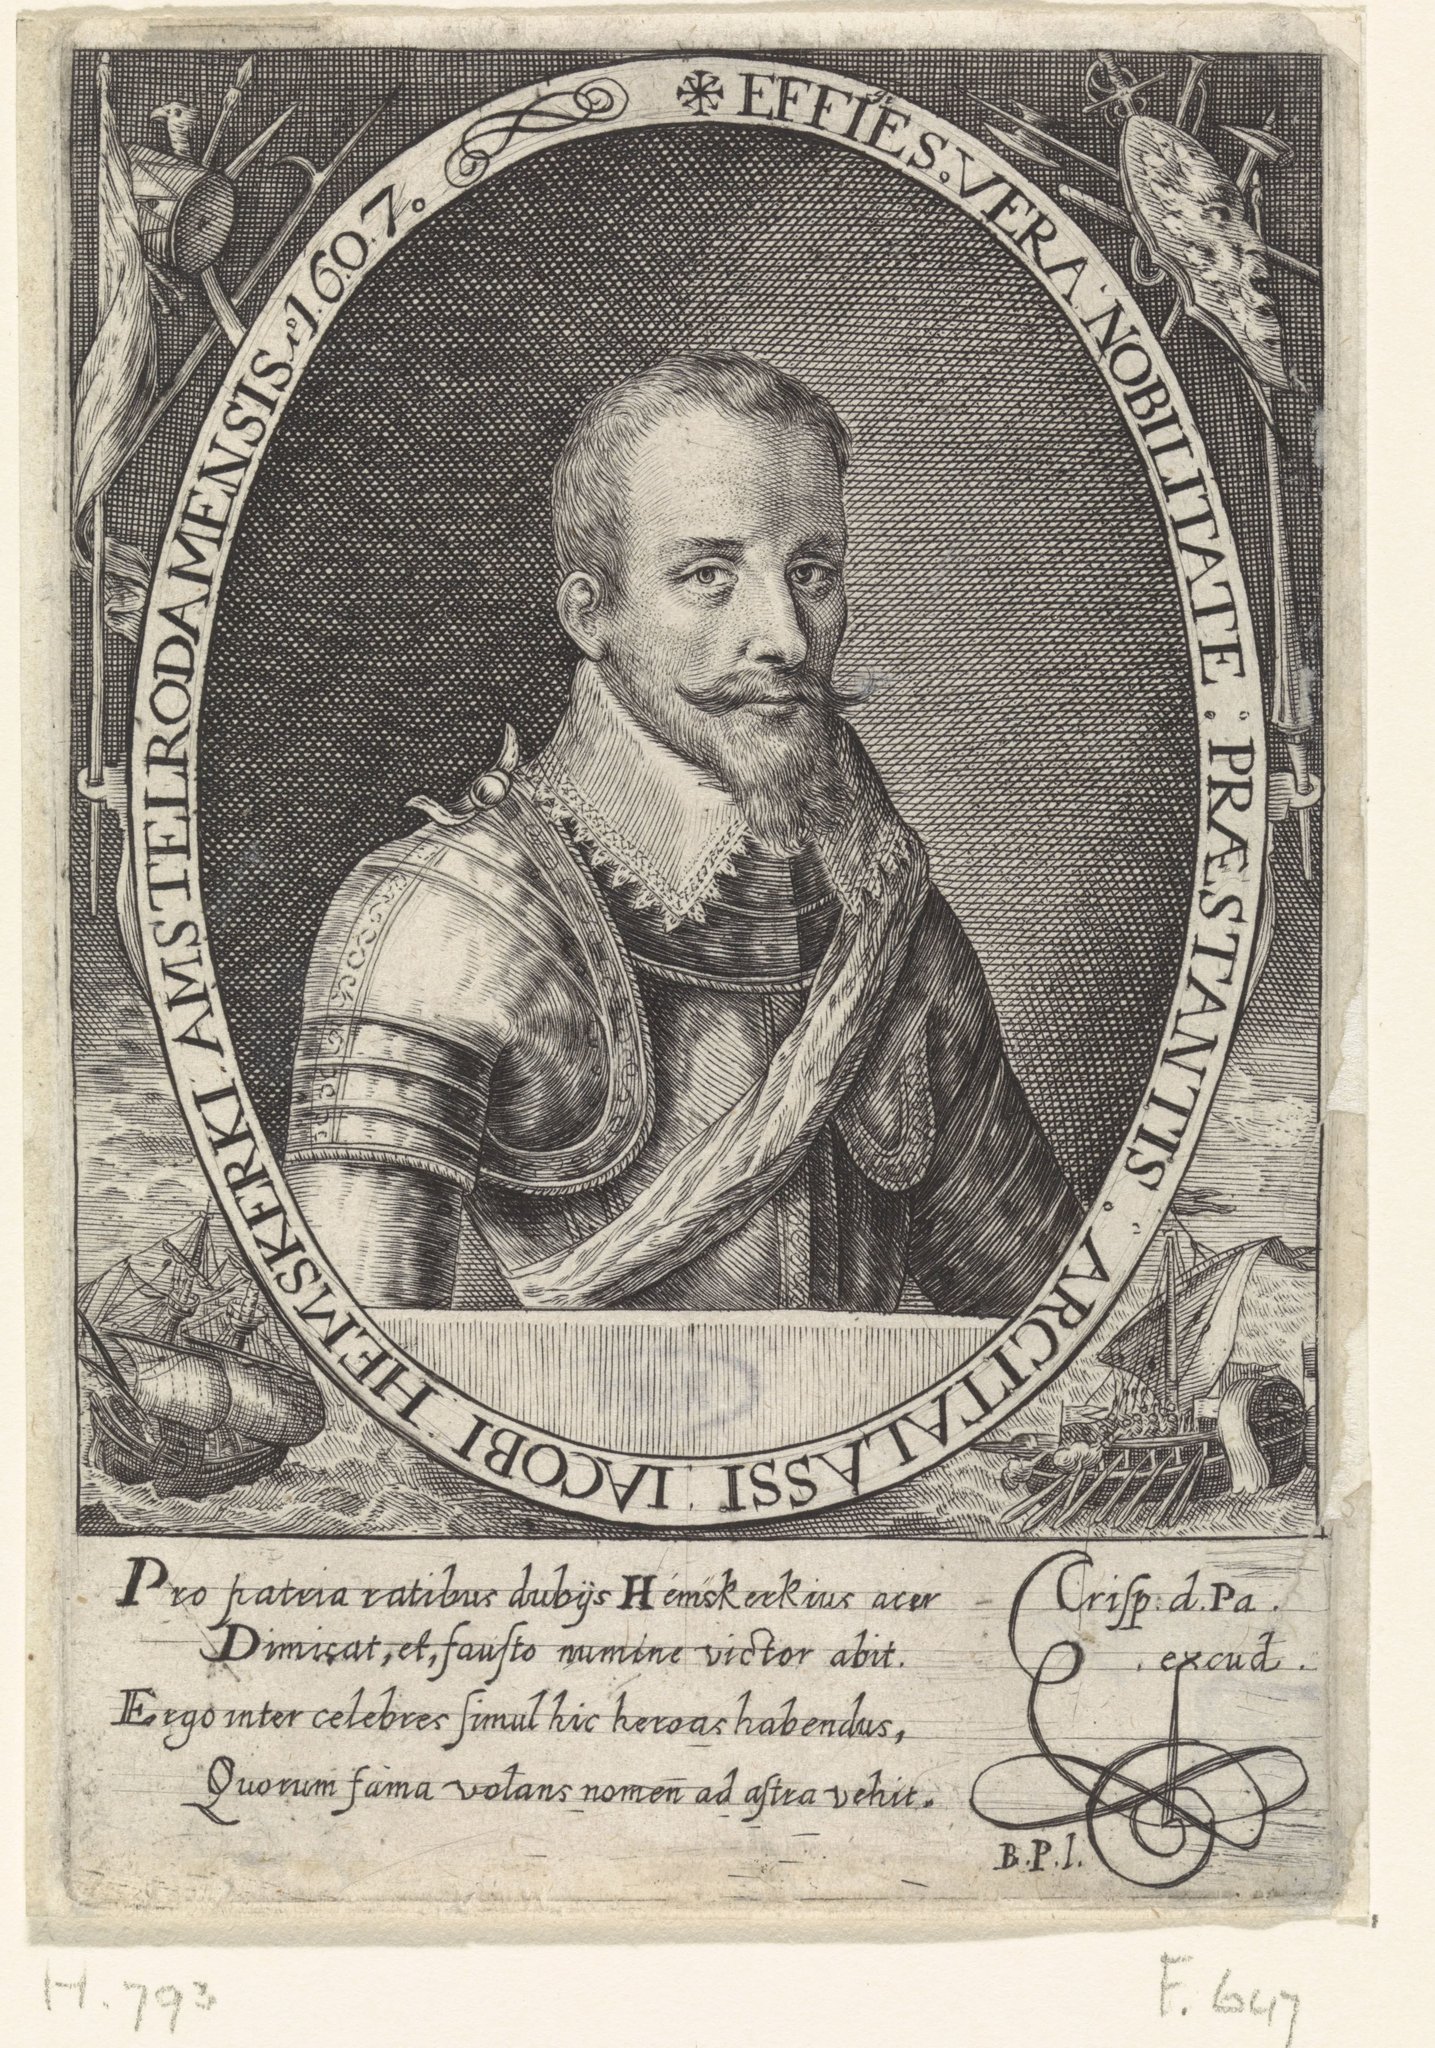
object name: print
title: Portret van Jacob van Heemskerck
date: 1607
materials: paper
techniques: engraving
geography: cologne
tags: amsterdam, jacob van heemskerck, ships (in general) - cc - more than one ship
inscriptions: collector's mark: Lugt 2228, collector's mark: Lugt 963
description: Portret van de admiraal Jacob van Heemskerck. In het randschrift van de omlijsting de naam en functie van de geportretteerde in het Latijn. Op de achtergrond twee schepen op zee. In de marge een vierregelig lofdicht in het Latijn.